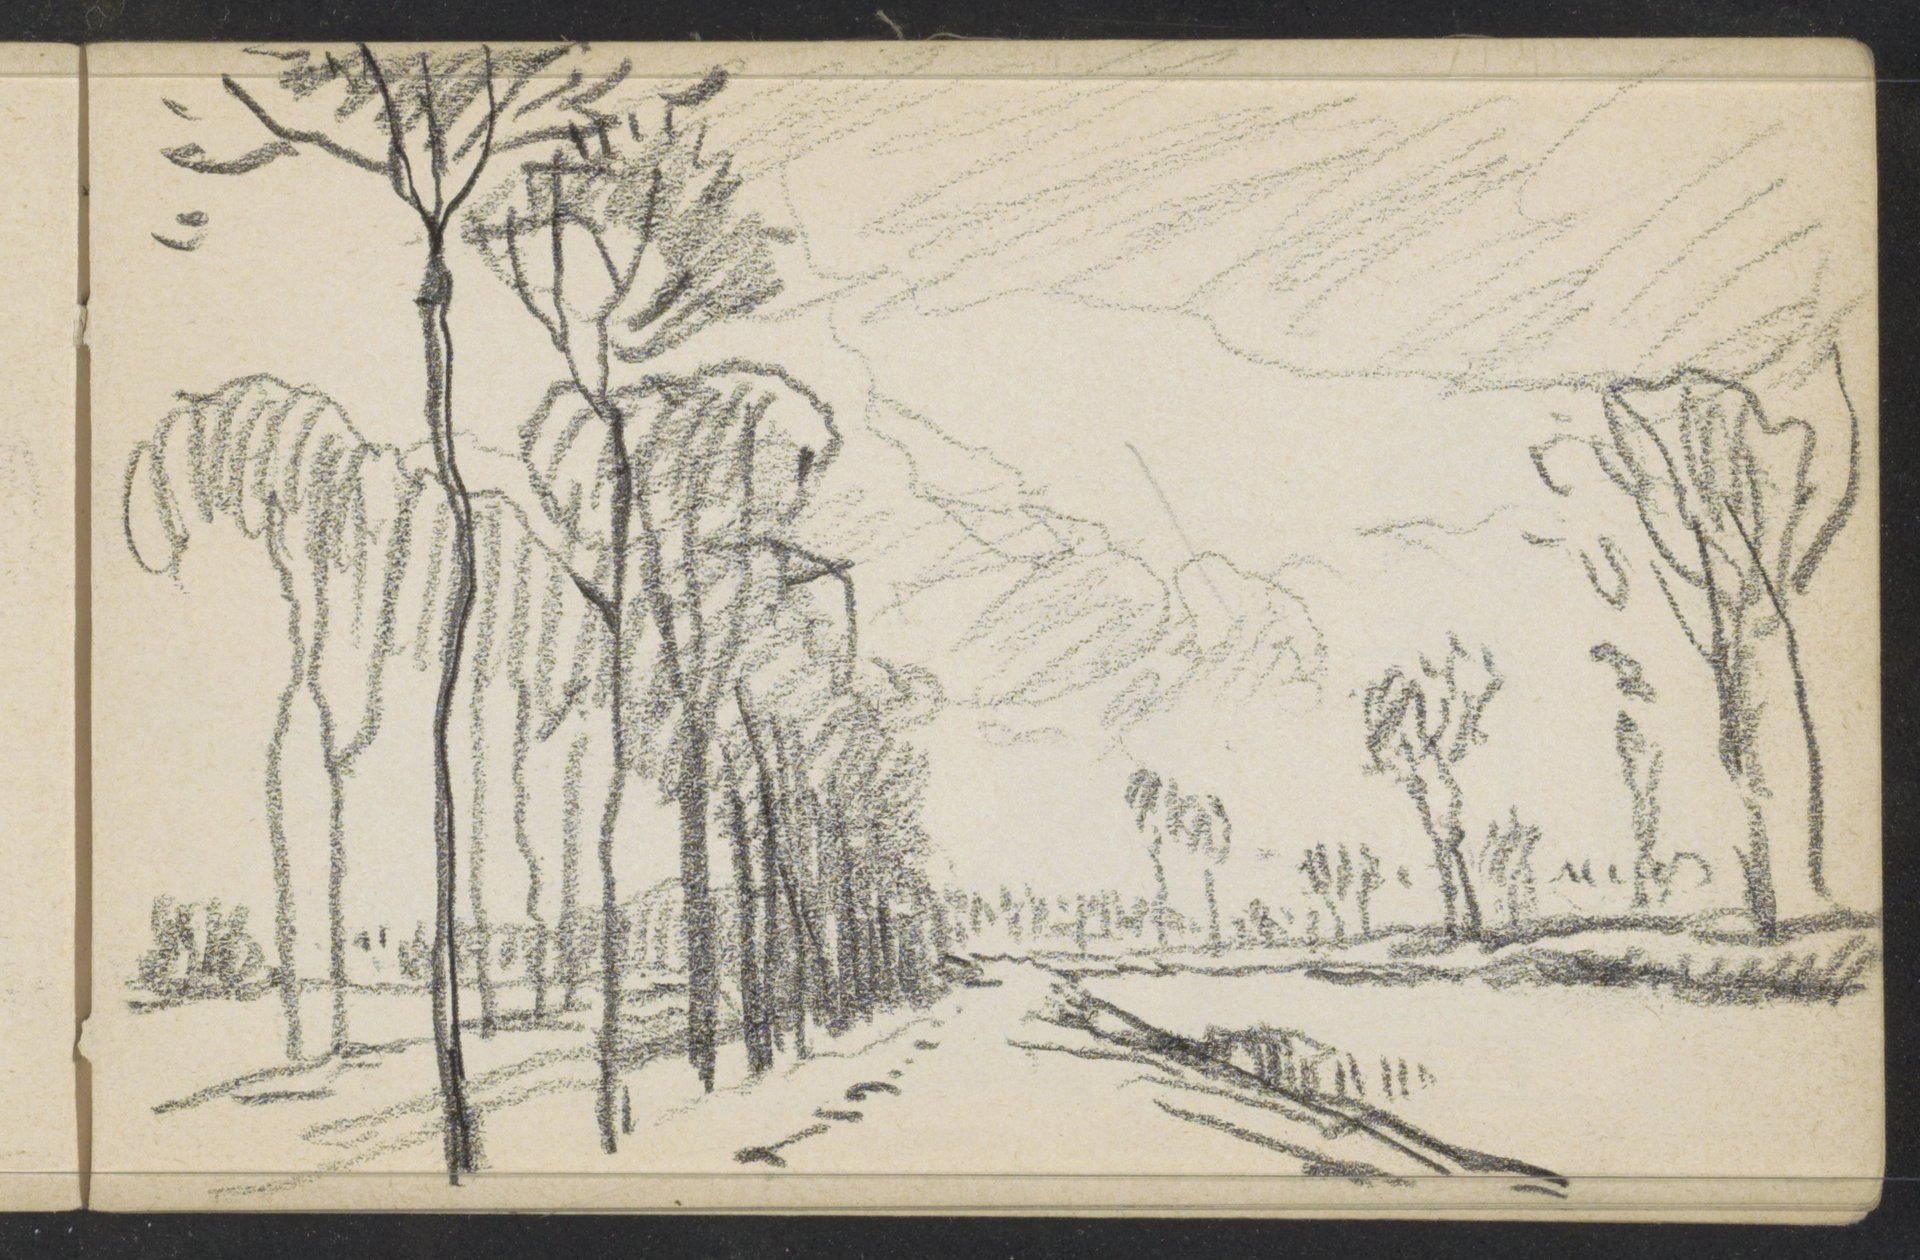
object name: sketchbook leaf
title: Pad in een landschap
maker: alexander shilling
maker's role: draughtsman, print maker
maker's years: 1859-1937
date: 1910-1923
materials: chalk, paper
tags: landscapes, fence, wall, paling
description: Blad 3 recto uit een schetsboek met 26 bladen.